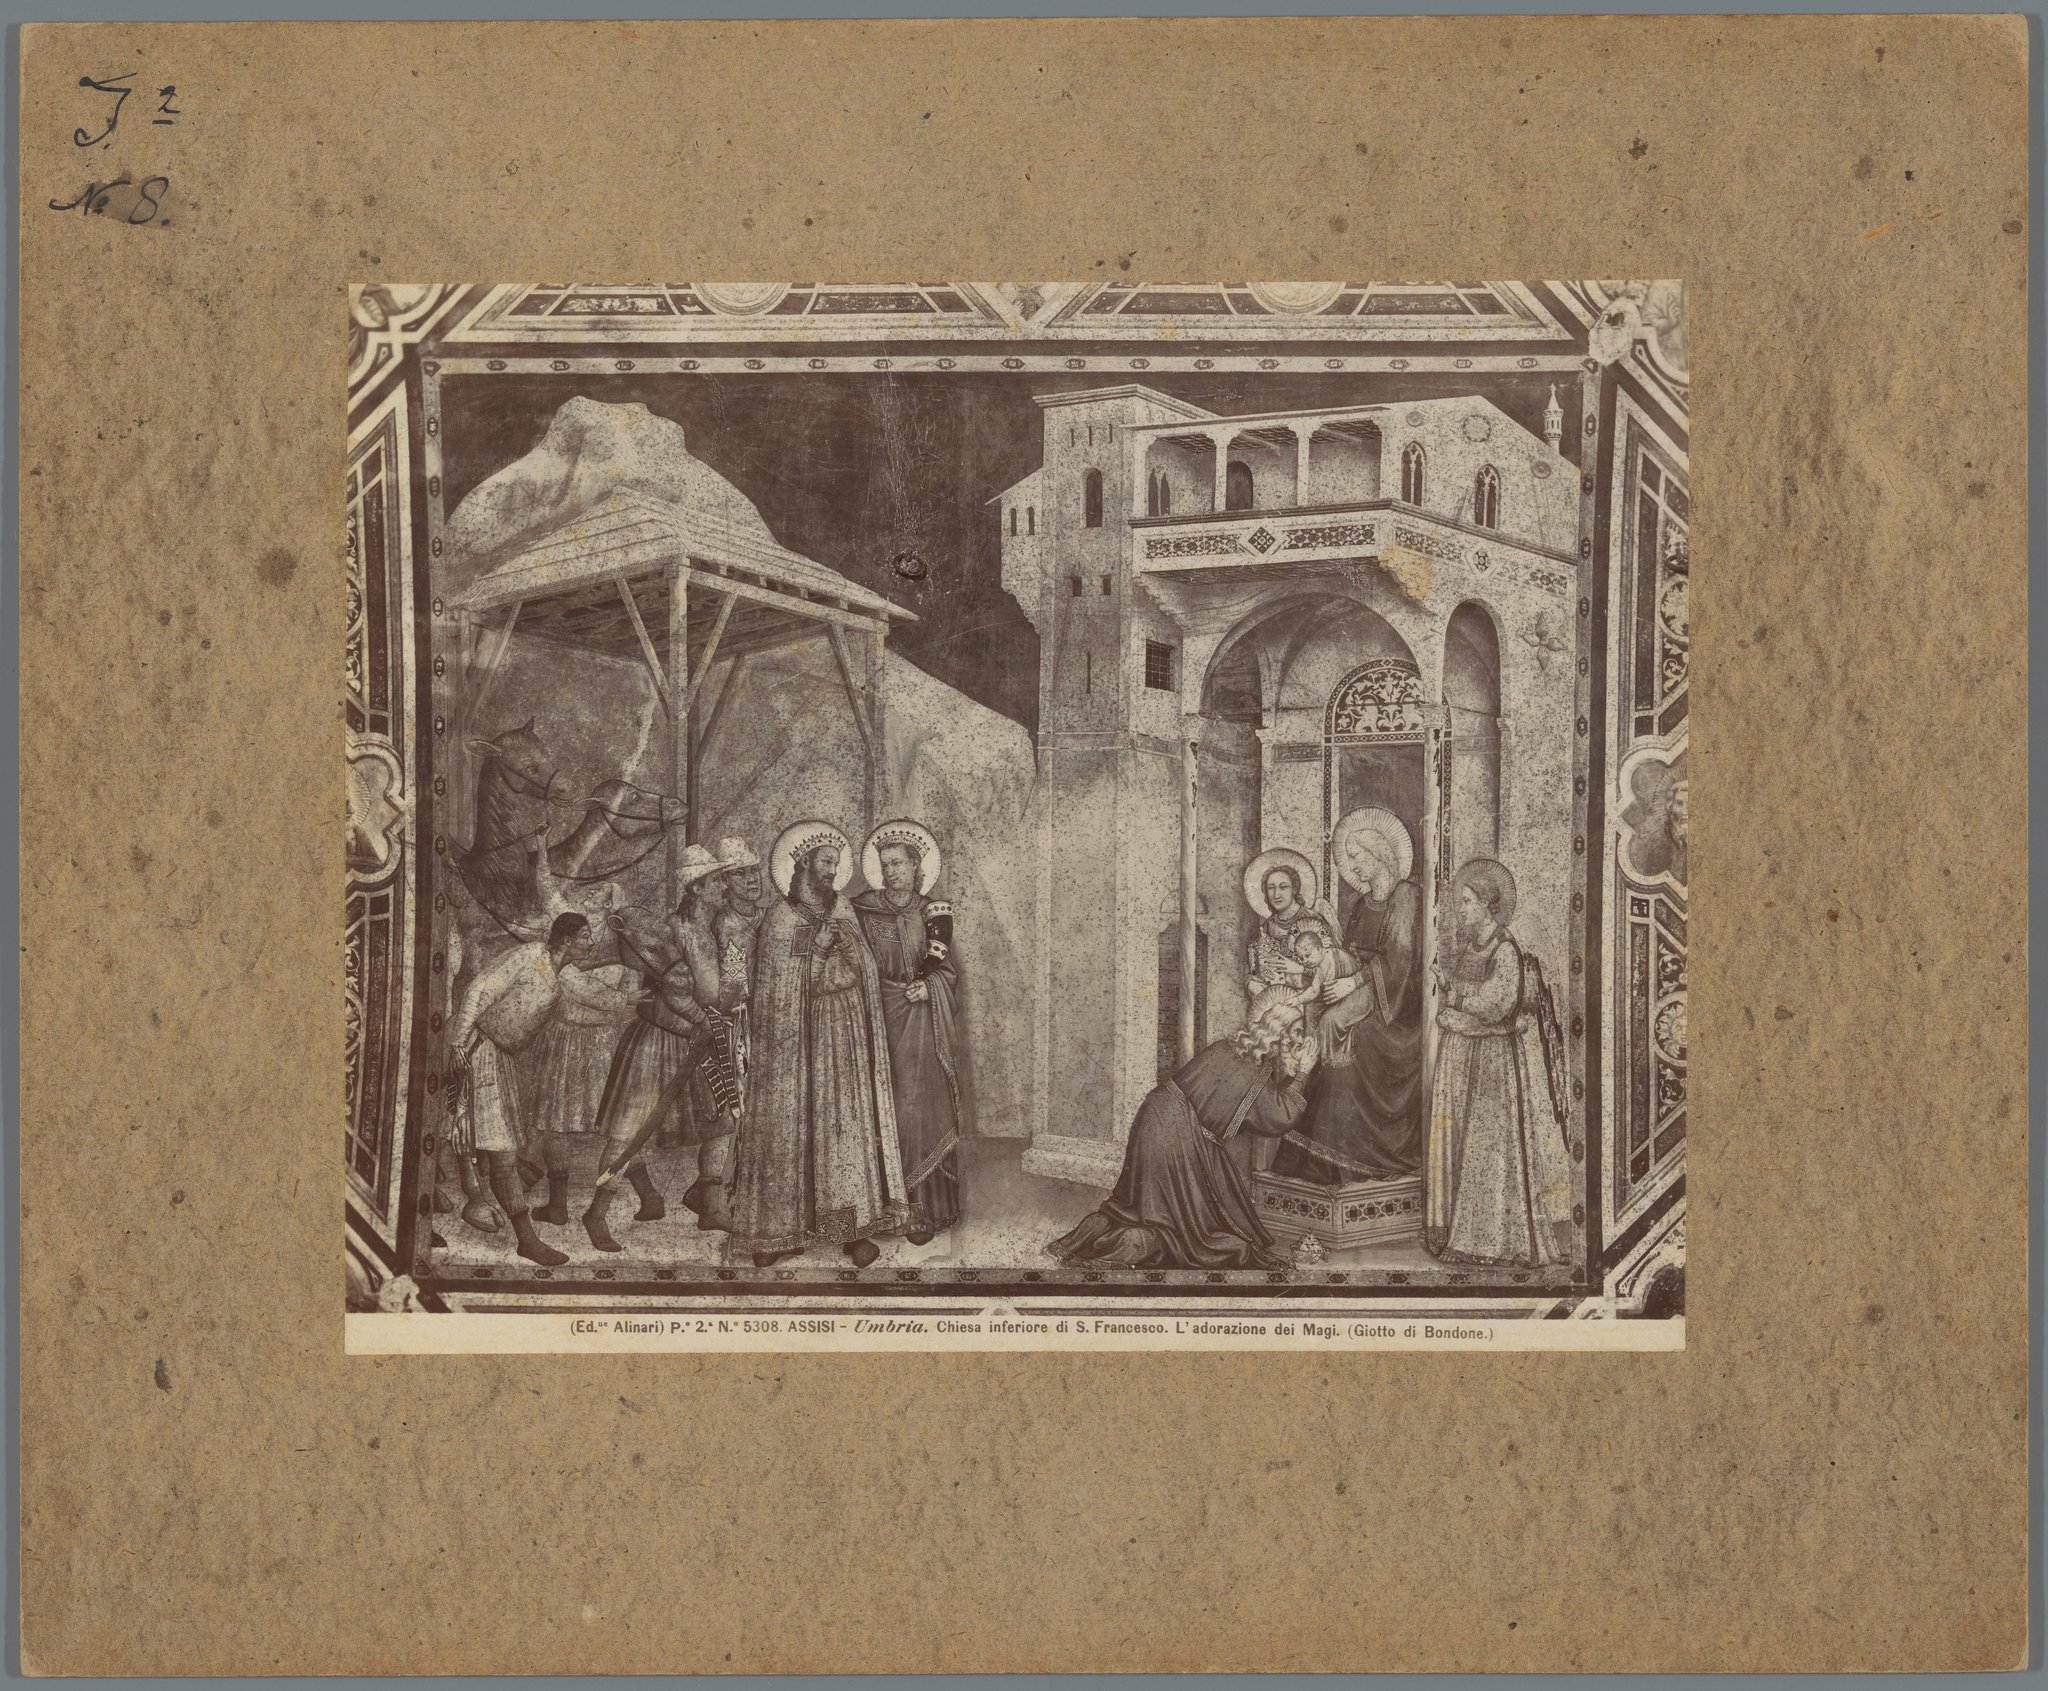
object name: photograph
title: Fotoreproductie van een schildering door Giotto, voorstellende de aanbidding door de koningen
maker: giotto de bondone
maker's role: painter, sculptor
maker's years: 1266-1337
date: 1875-1900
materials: cardboard, photographic support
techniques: albumen print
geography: sint-franciscusbasiliek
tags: adoration of the kings: the wise men present their gifts to the christ-child (gold, frankincense and myrrh)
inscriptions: collector's mark: Lugt 3937, number: ‘P.e 2.a N.o 5308.’